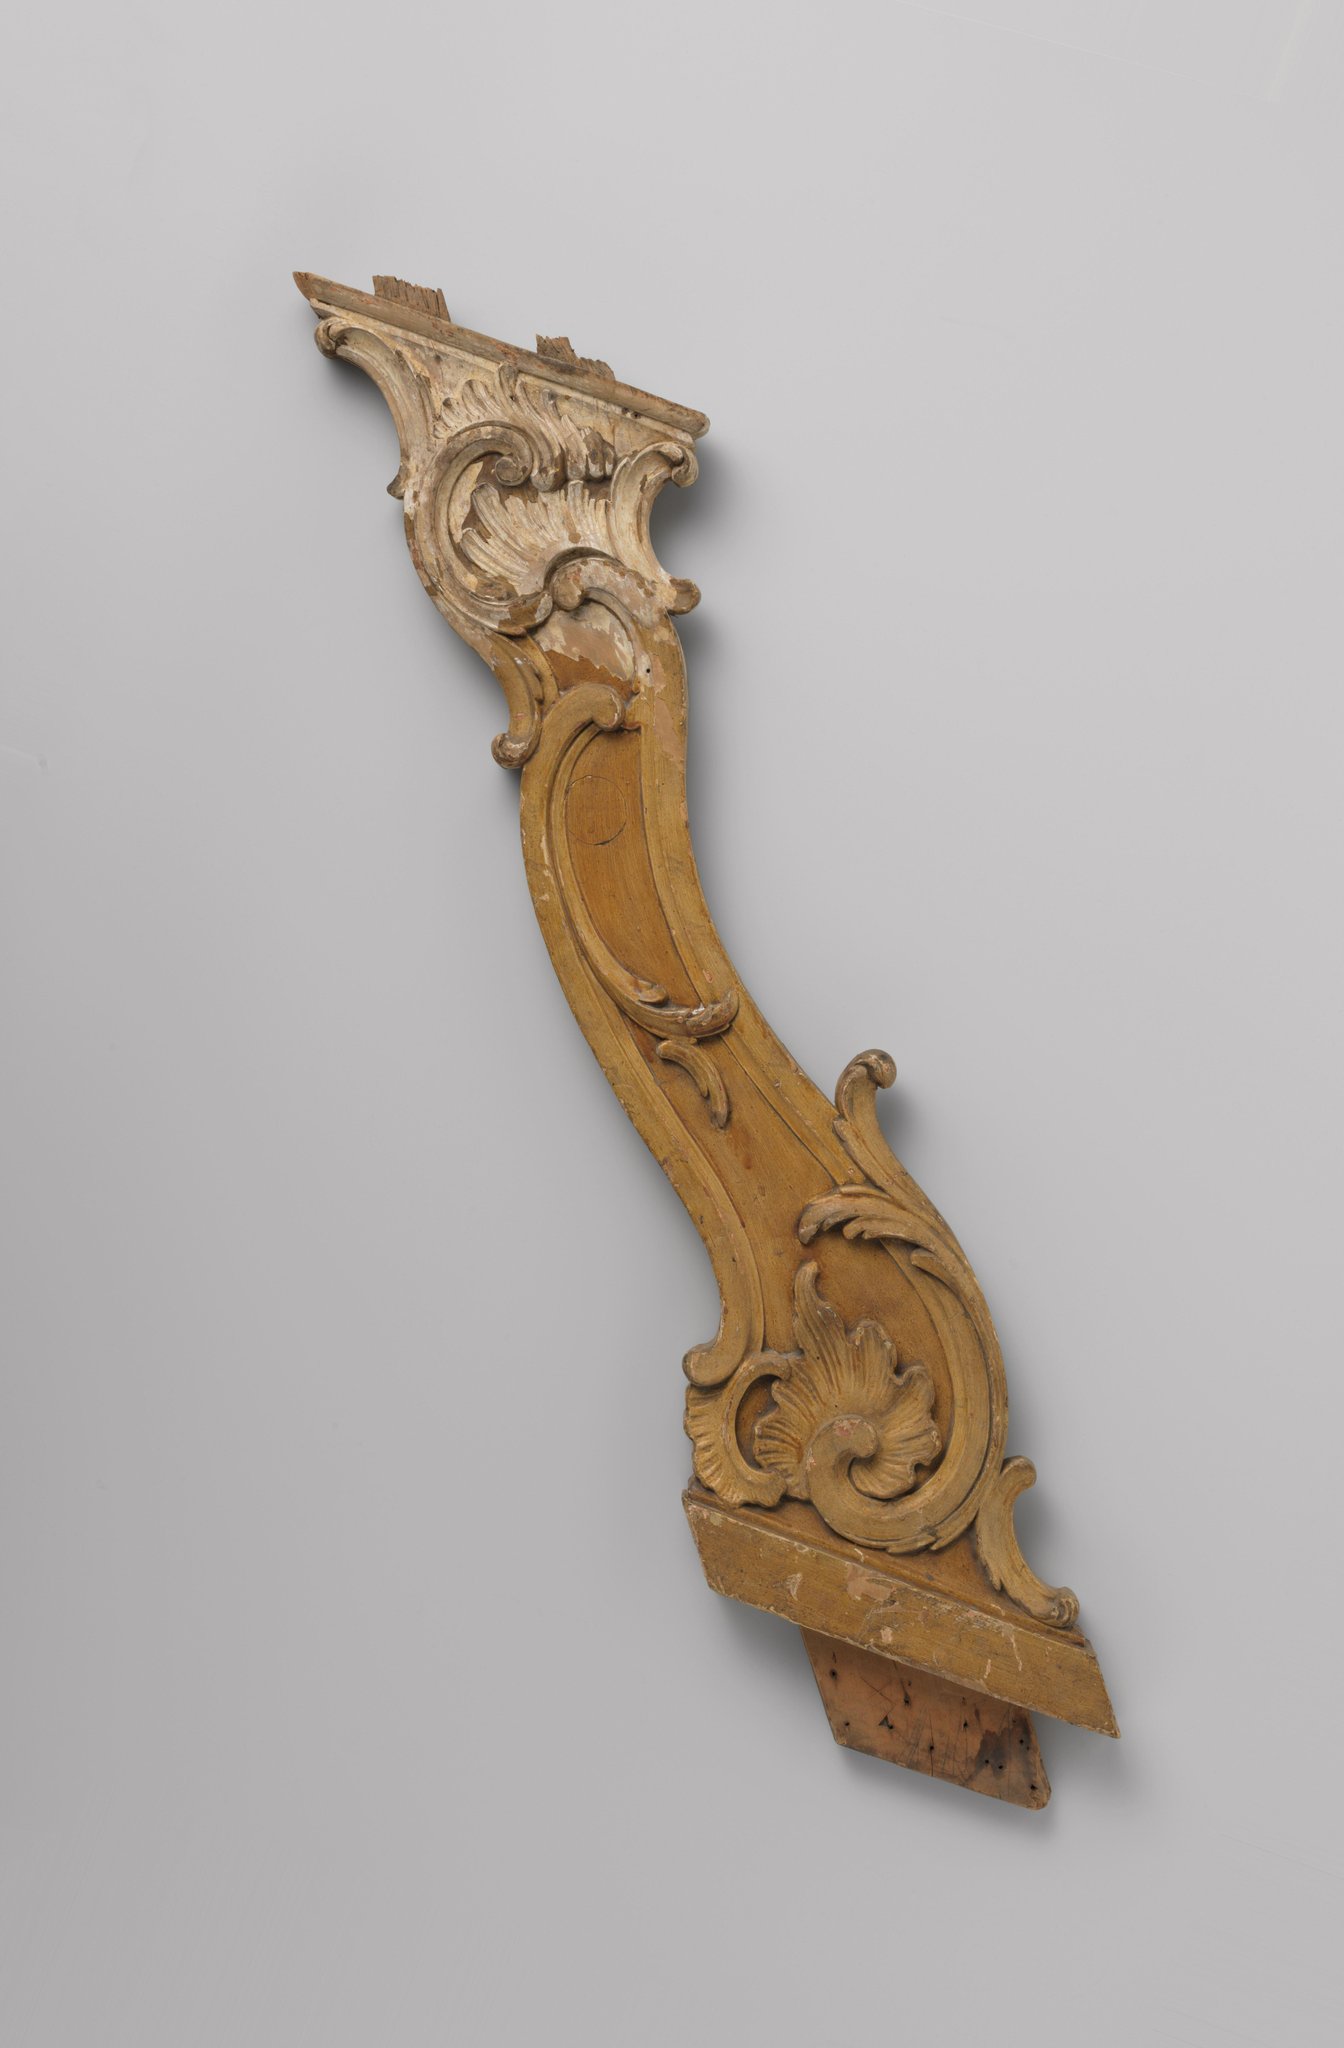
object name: stair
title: Baluster met gestoken C- en S-voluten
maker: Anonymous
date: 1740-1760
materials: wood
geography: northern netherlands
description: S-vormige baluster met gestoken C- en S-voluten met rocaille-schelpen.